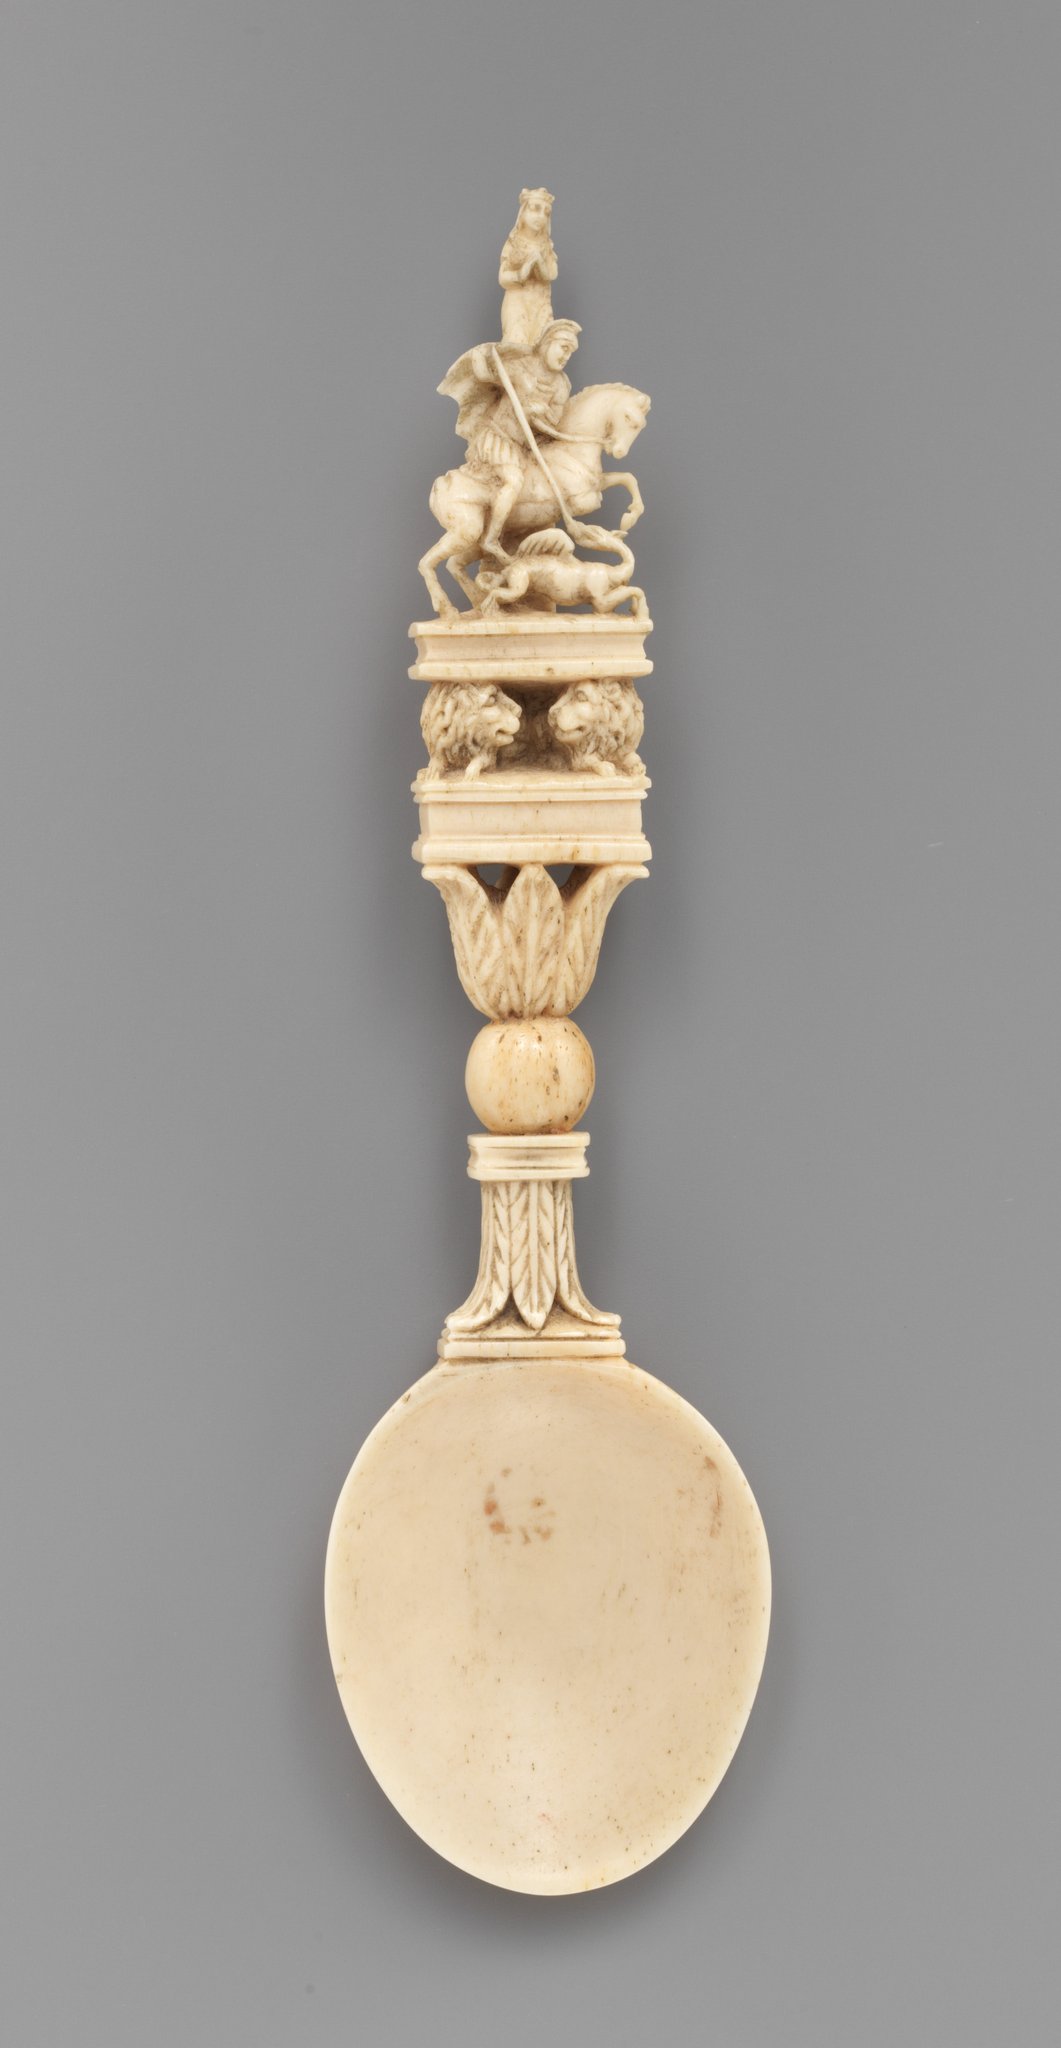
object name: spoon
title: Saint George slaying the dragon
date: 1501-1600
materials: ivory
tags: men,dragons,horses,lions,saint george